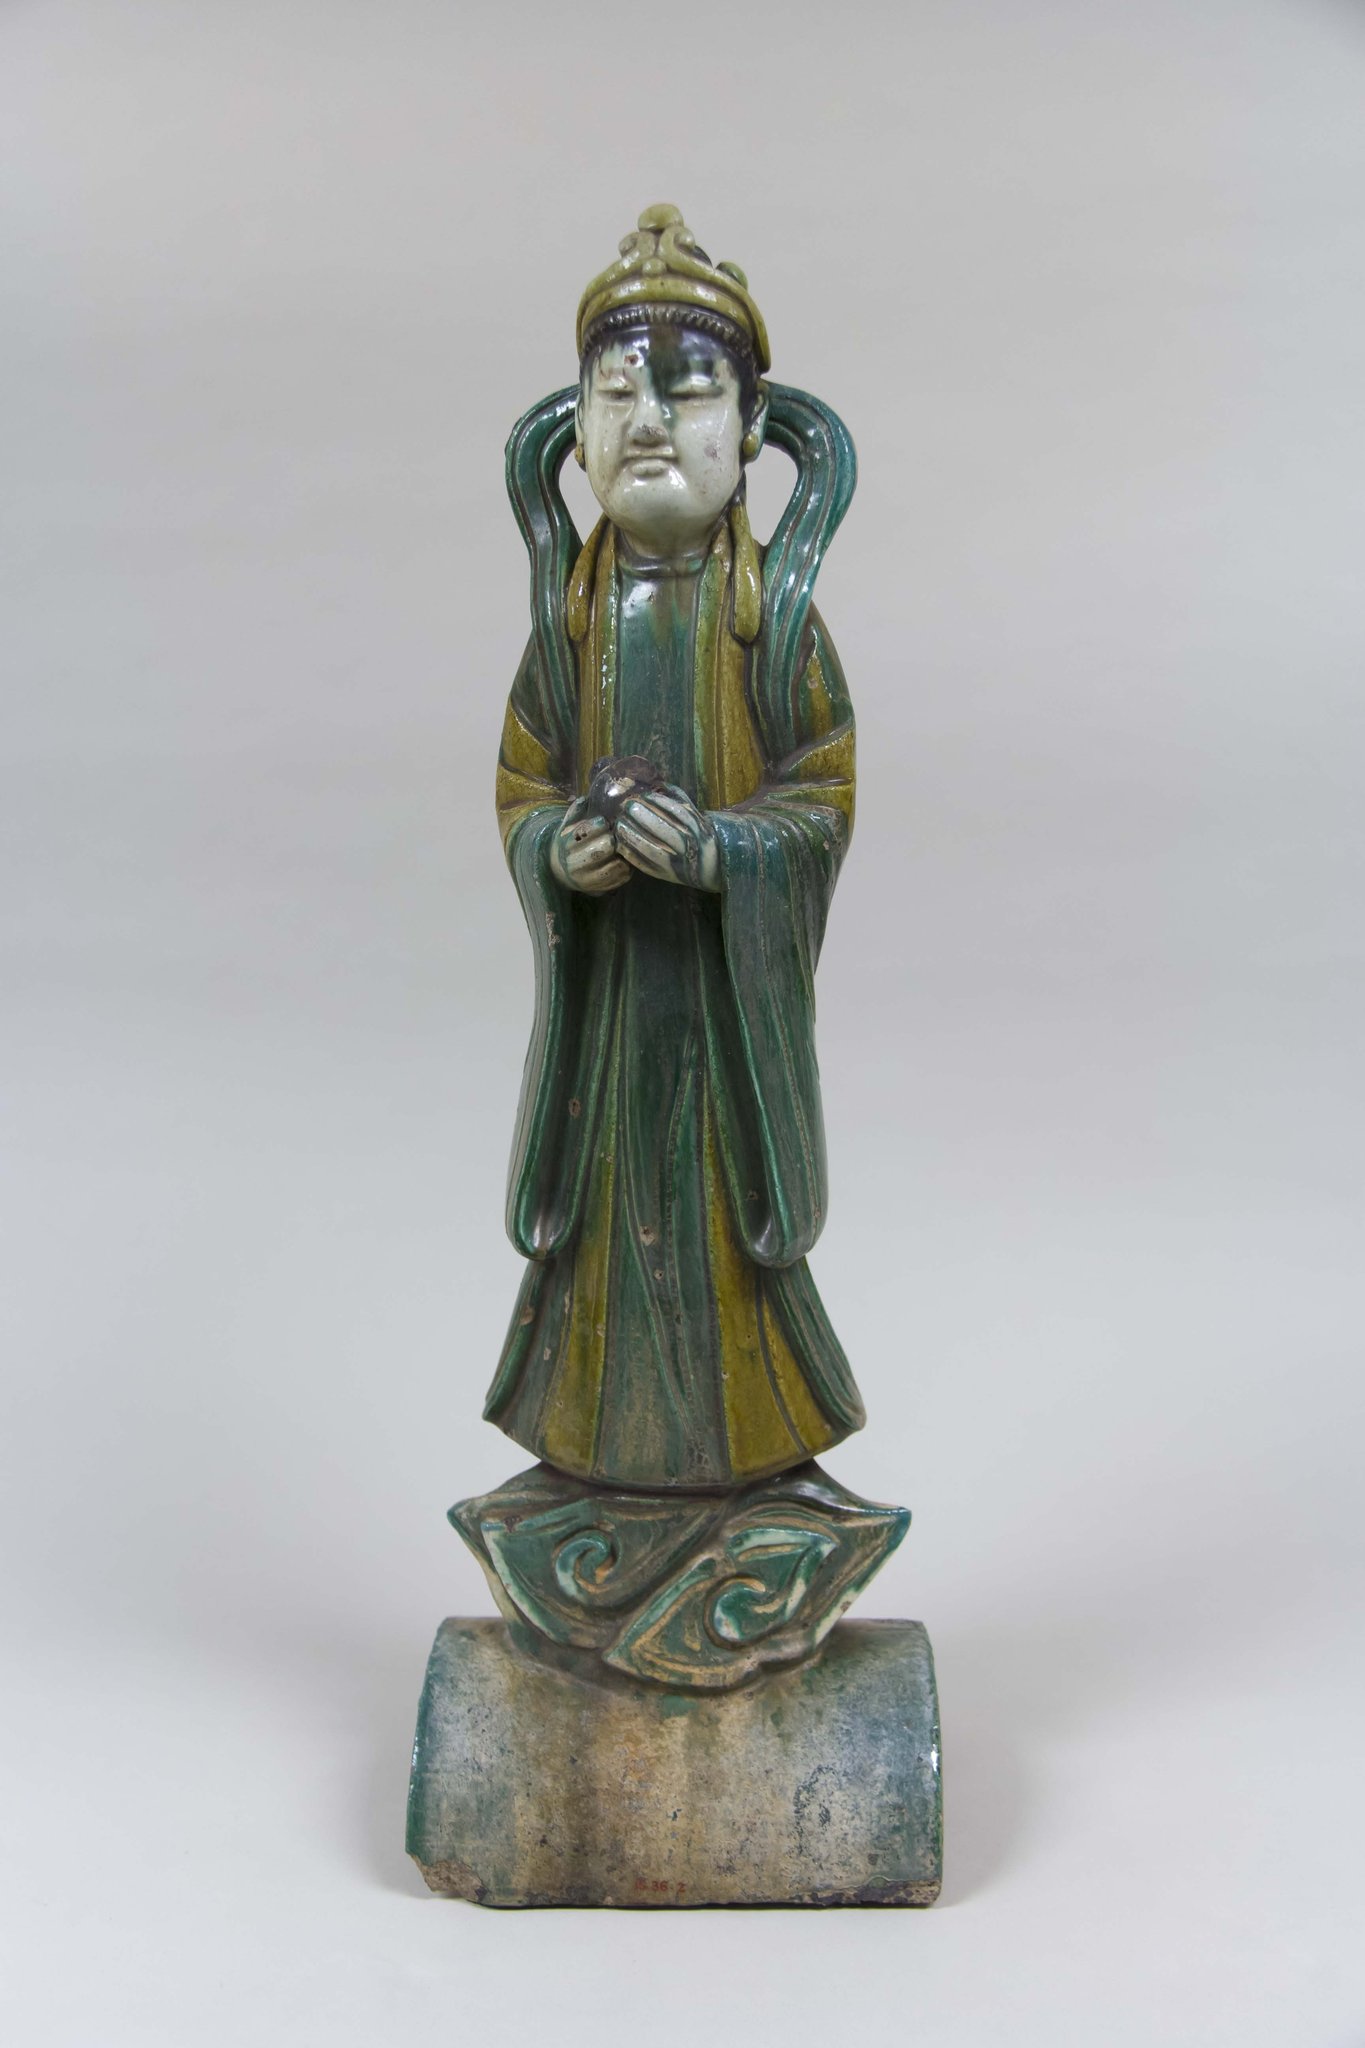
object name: roof tile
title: Roof tile with a standing figure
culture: chinese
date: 1401-1600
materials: enamel, stoneware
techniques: polychrome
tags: men